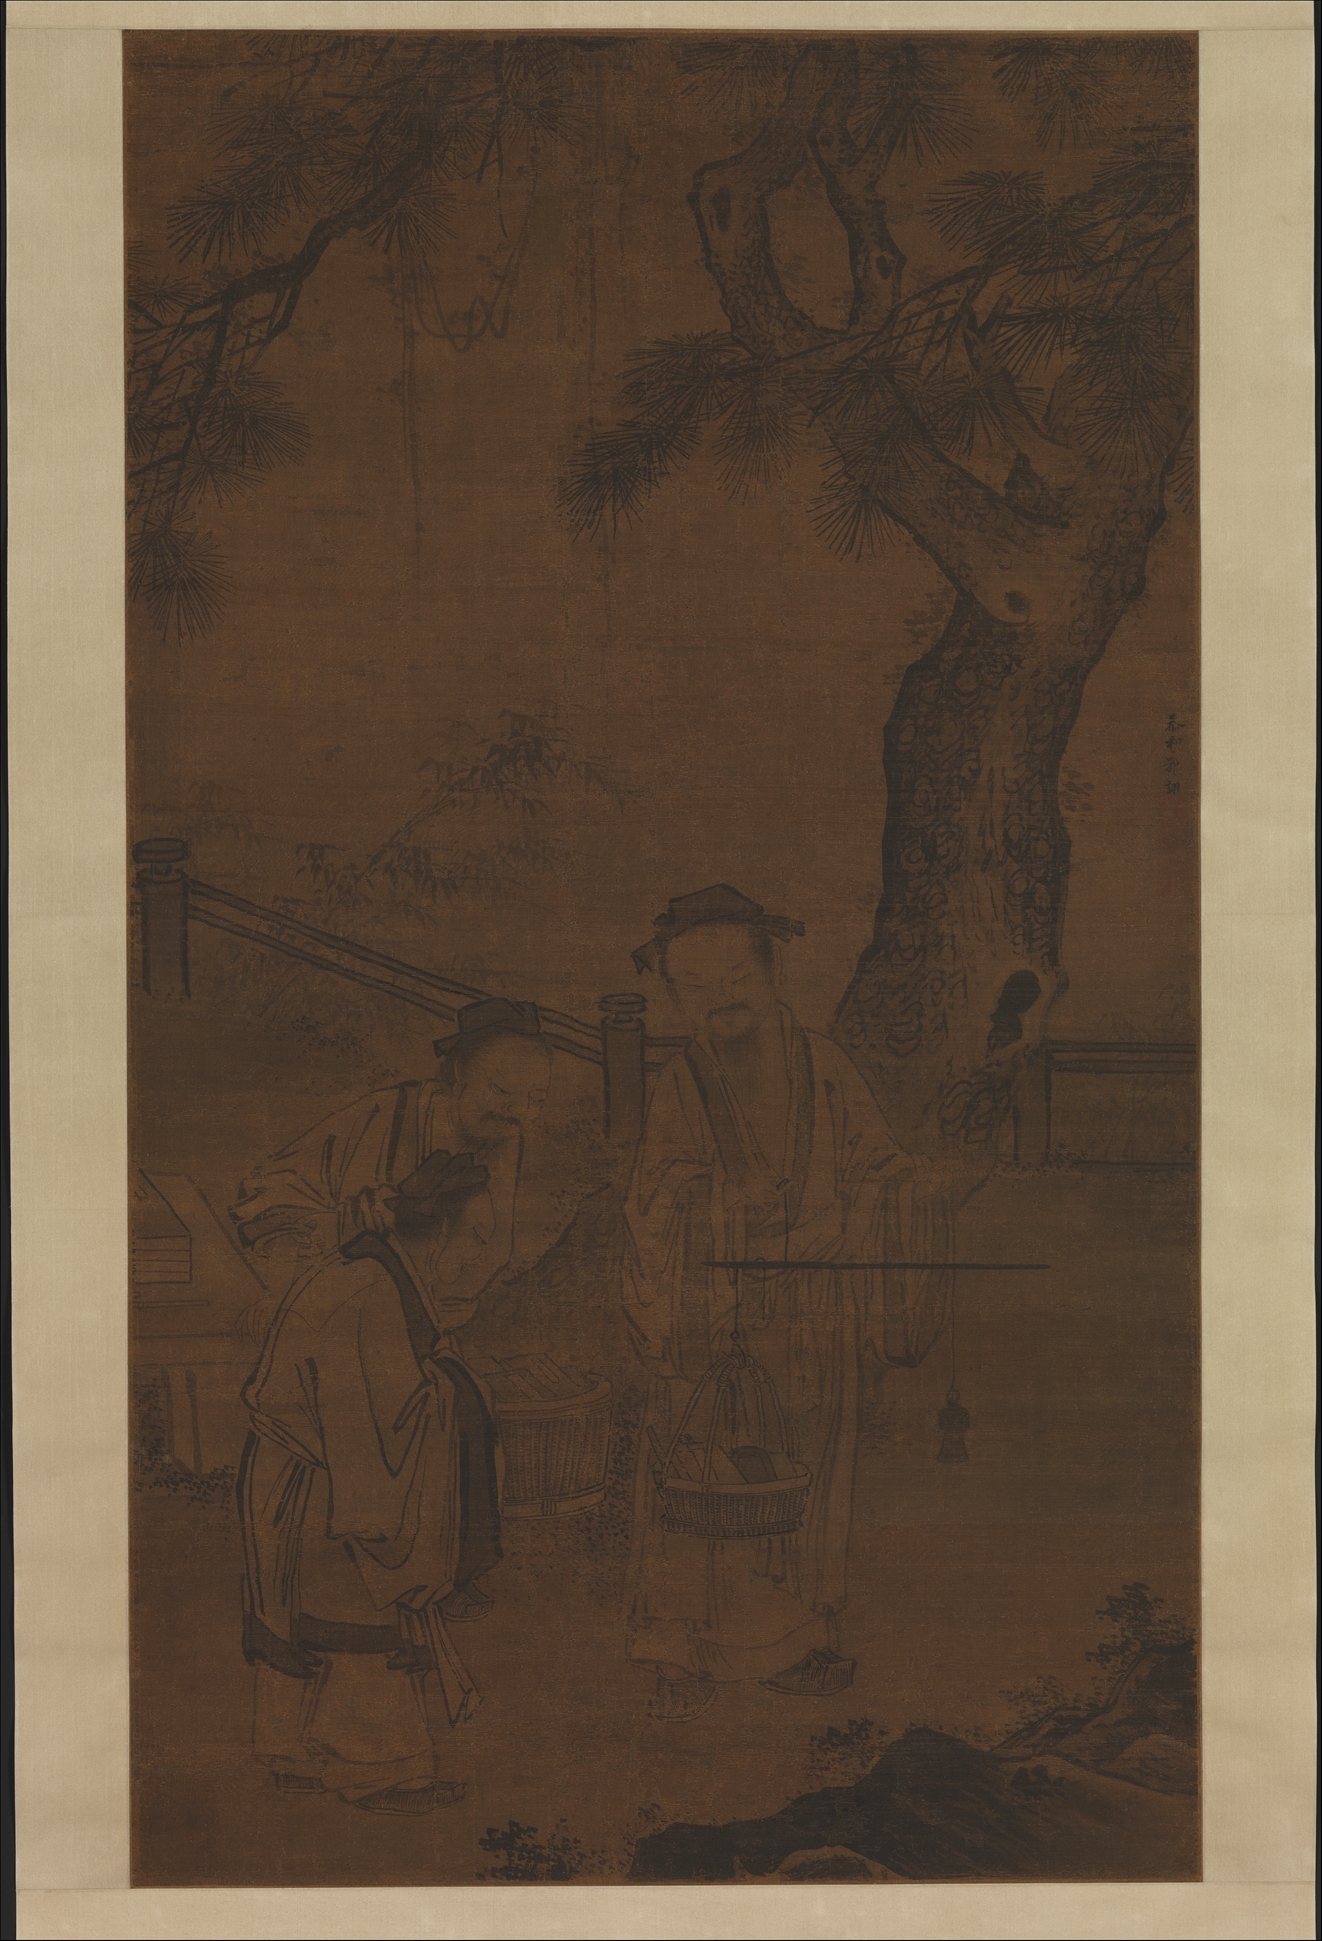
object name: hanging scroll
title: Weighing Books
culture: chinese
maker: guo xu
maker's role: artist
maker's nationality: chinese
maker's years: 1456-1532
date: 1501-1533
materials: ink, silk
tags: books,men,scales